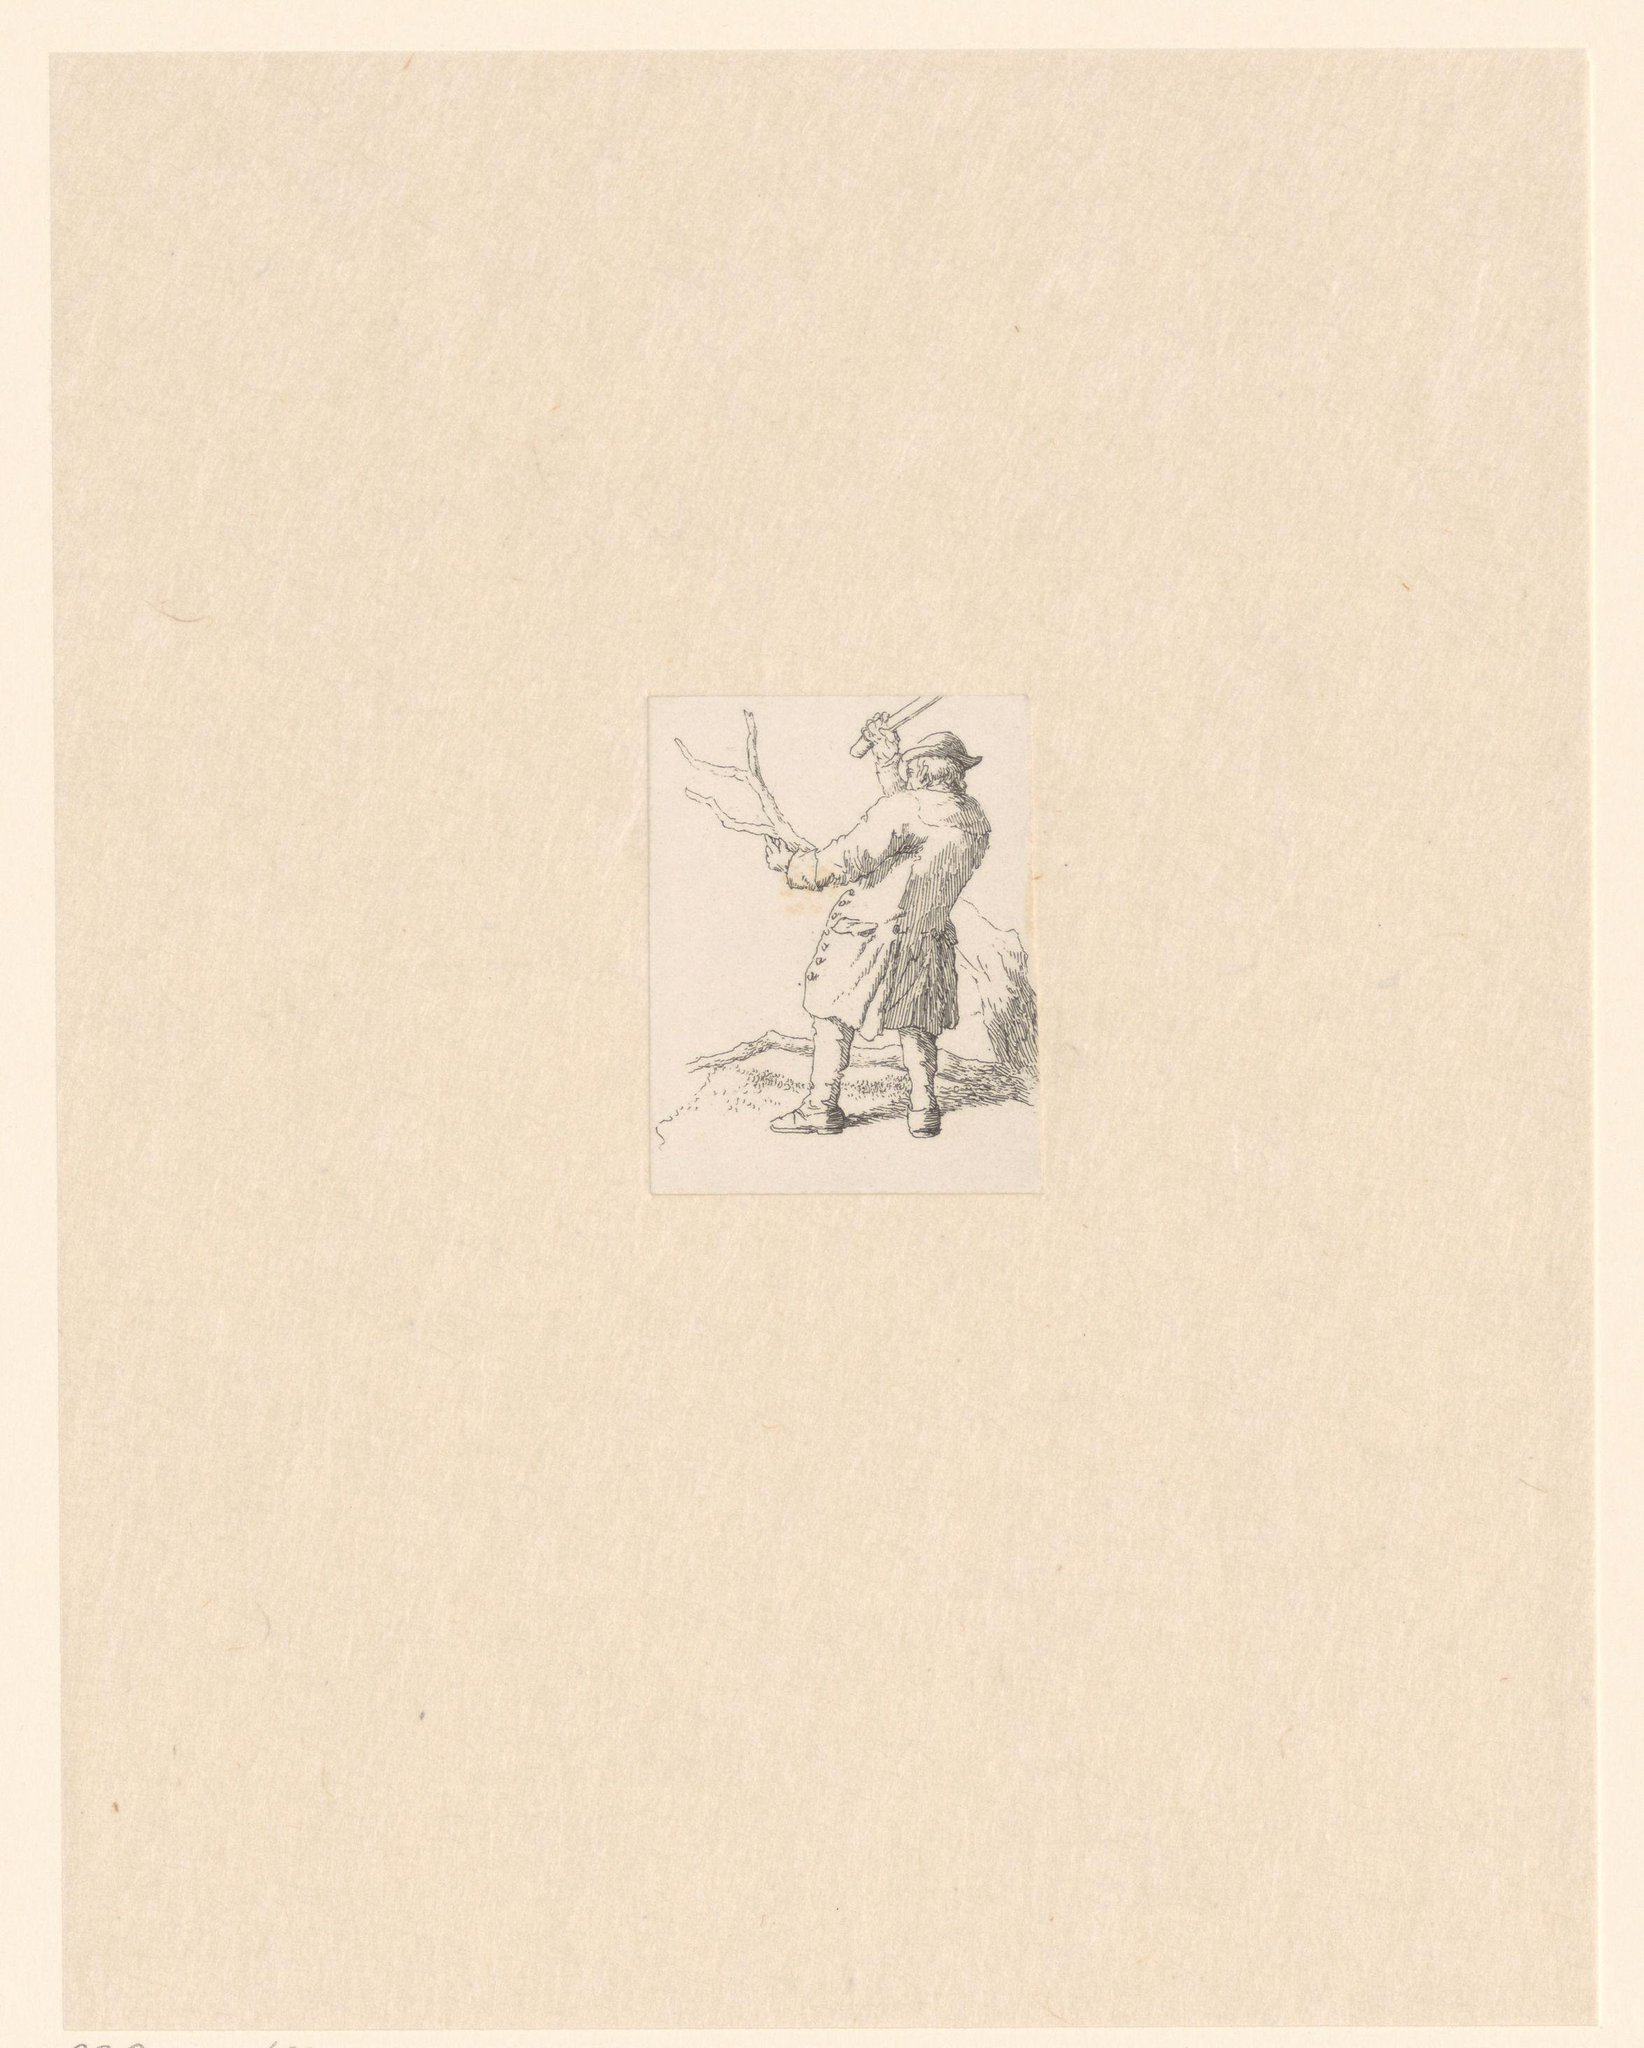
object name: print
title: Staande man hakt boomtakken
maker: william henry pyne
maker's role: print maker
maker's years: 1769-1843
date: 1779-1843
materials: paper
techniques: etching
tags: standing figure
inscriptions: collector's mark: Lugt 2228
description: Prent is mogelijk gebruikt in: Pyne, William Henry. Microcosm: or, a picturesque delineation of the arts, agriculture, manufactures, &c. of Great Britain. Londen: William Henry Pyne & John Claude Nattes, 1806.